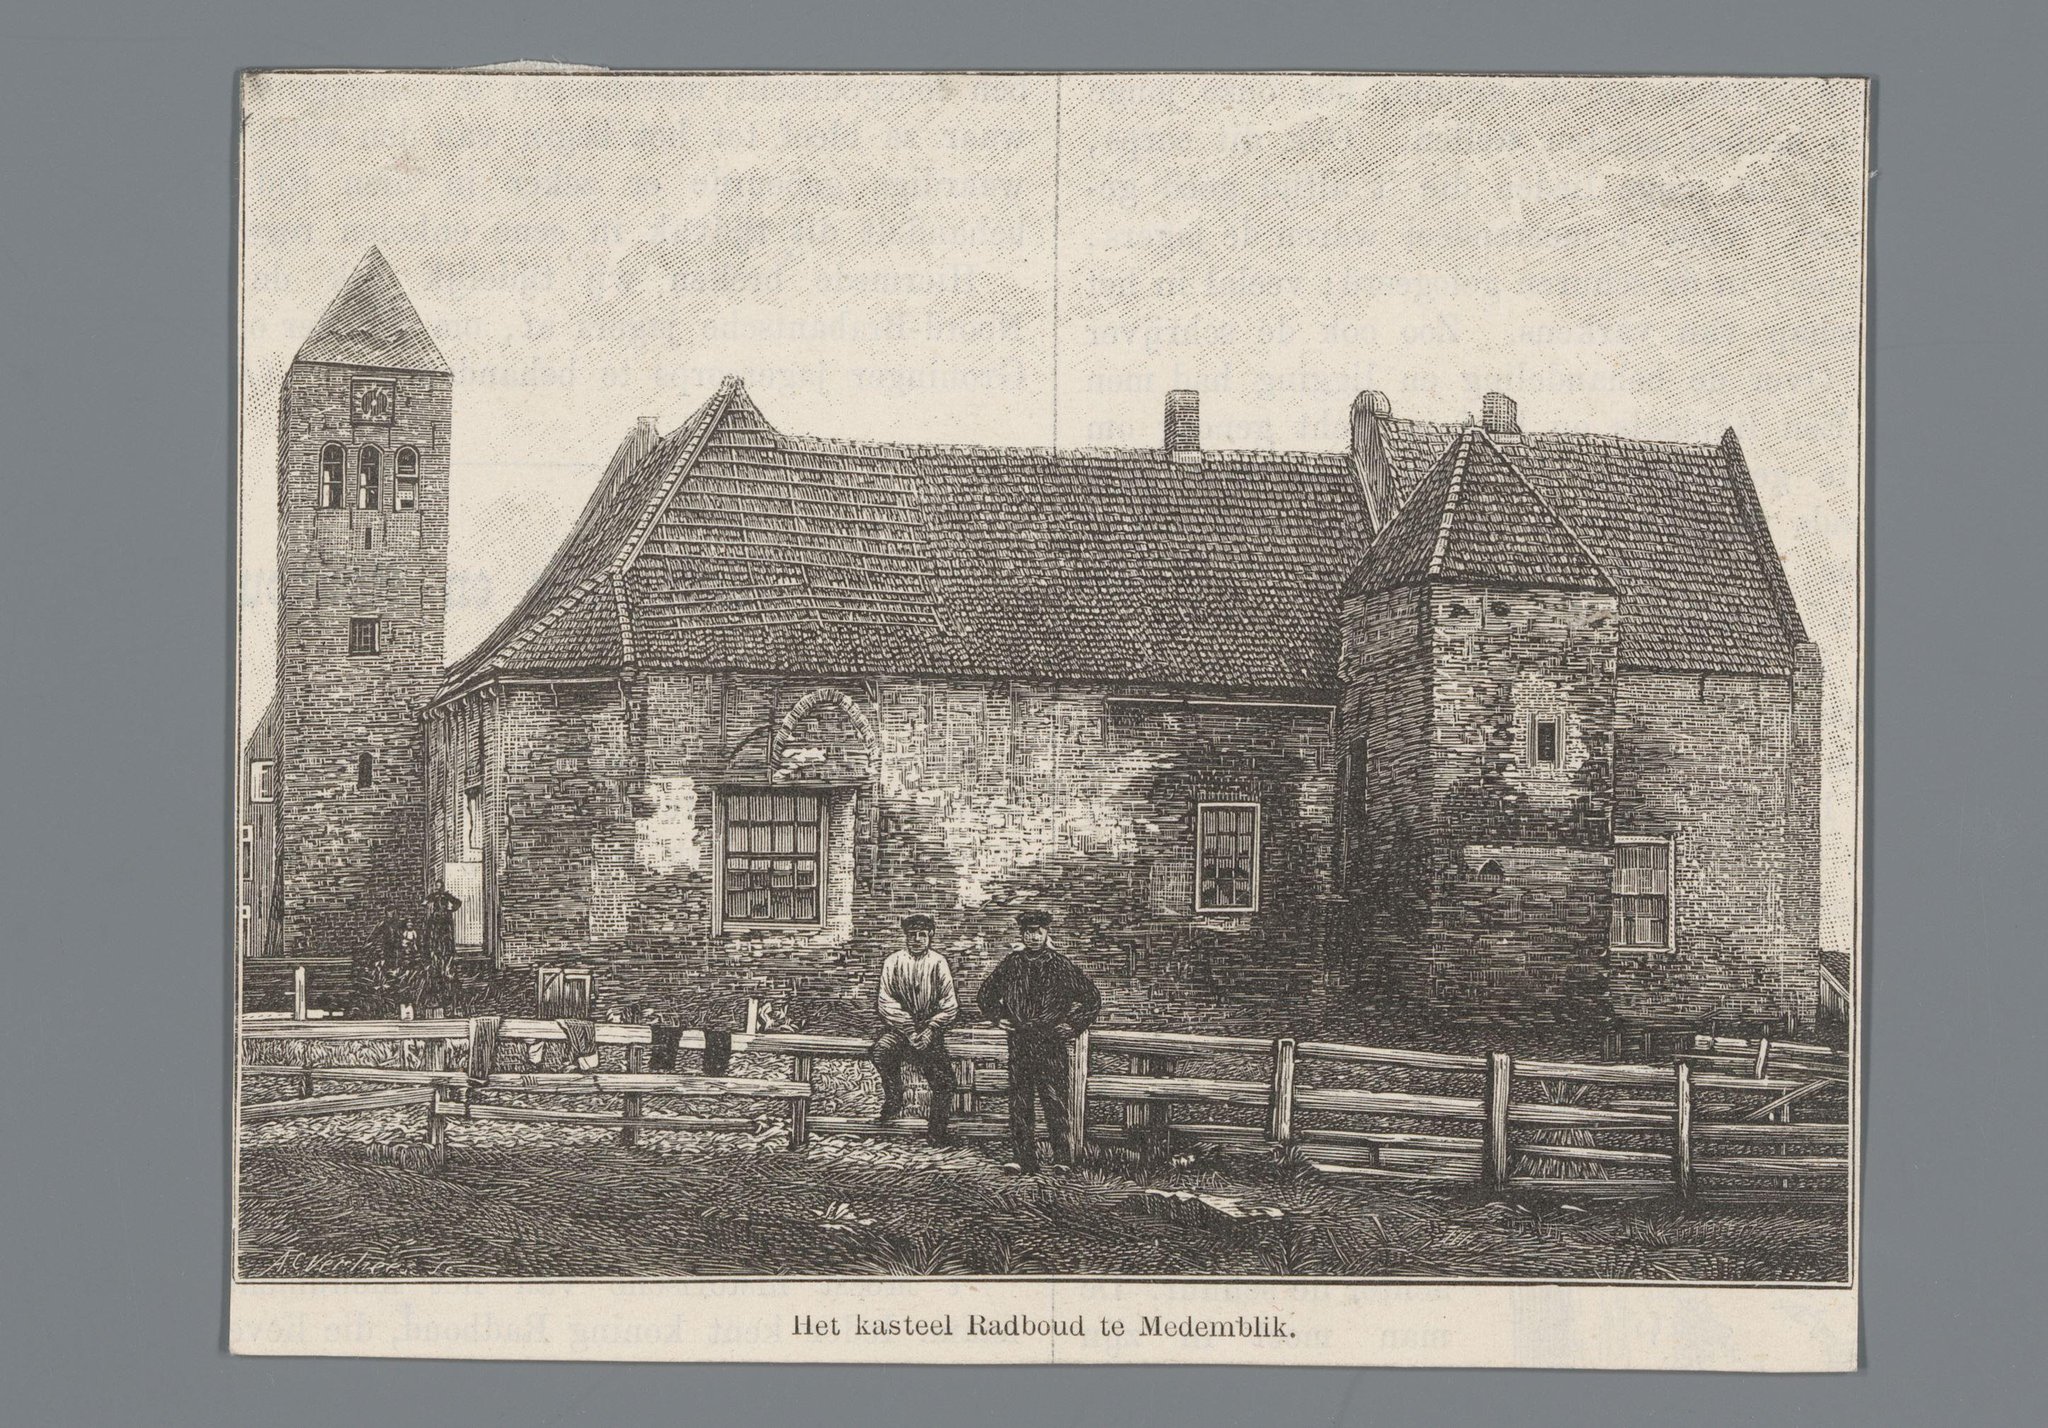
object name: print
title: Gezicht op kasteel Radboud in Medemblik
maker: arnoldus cornelius verhees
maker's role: print maker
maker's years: 1859-1929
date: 1825-1925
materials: paper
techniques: letterpress printing, engraving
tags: castle